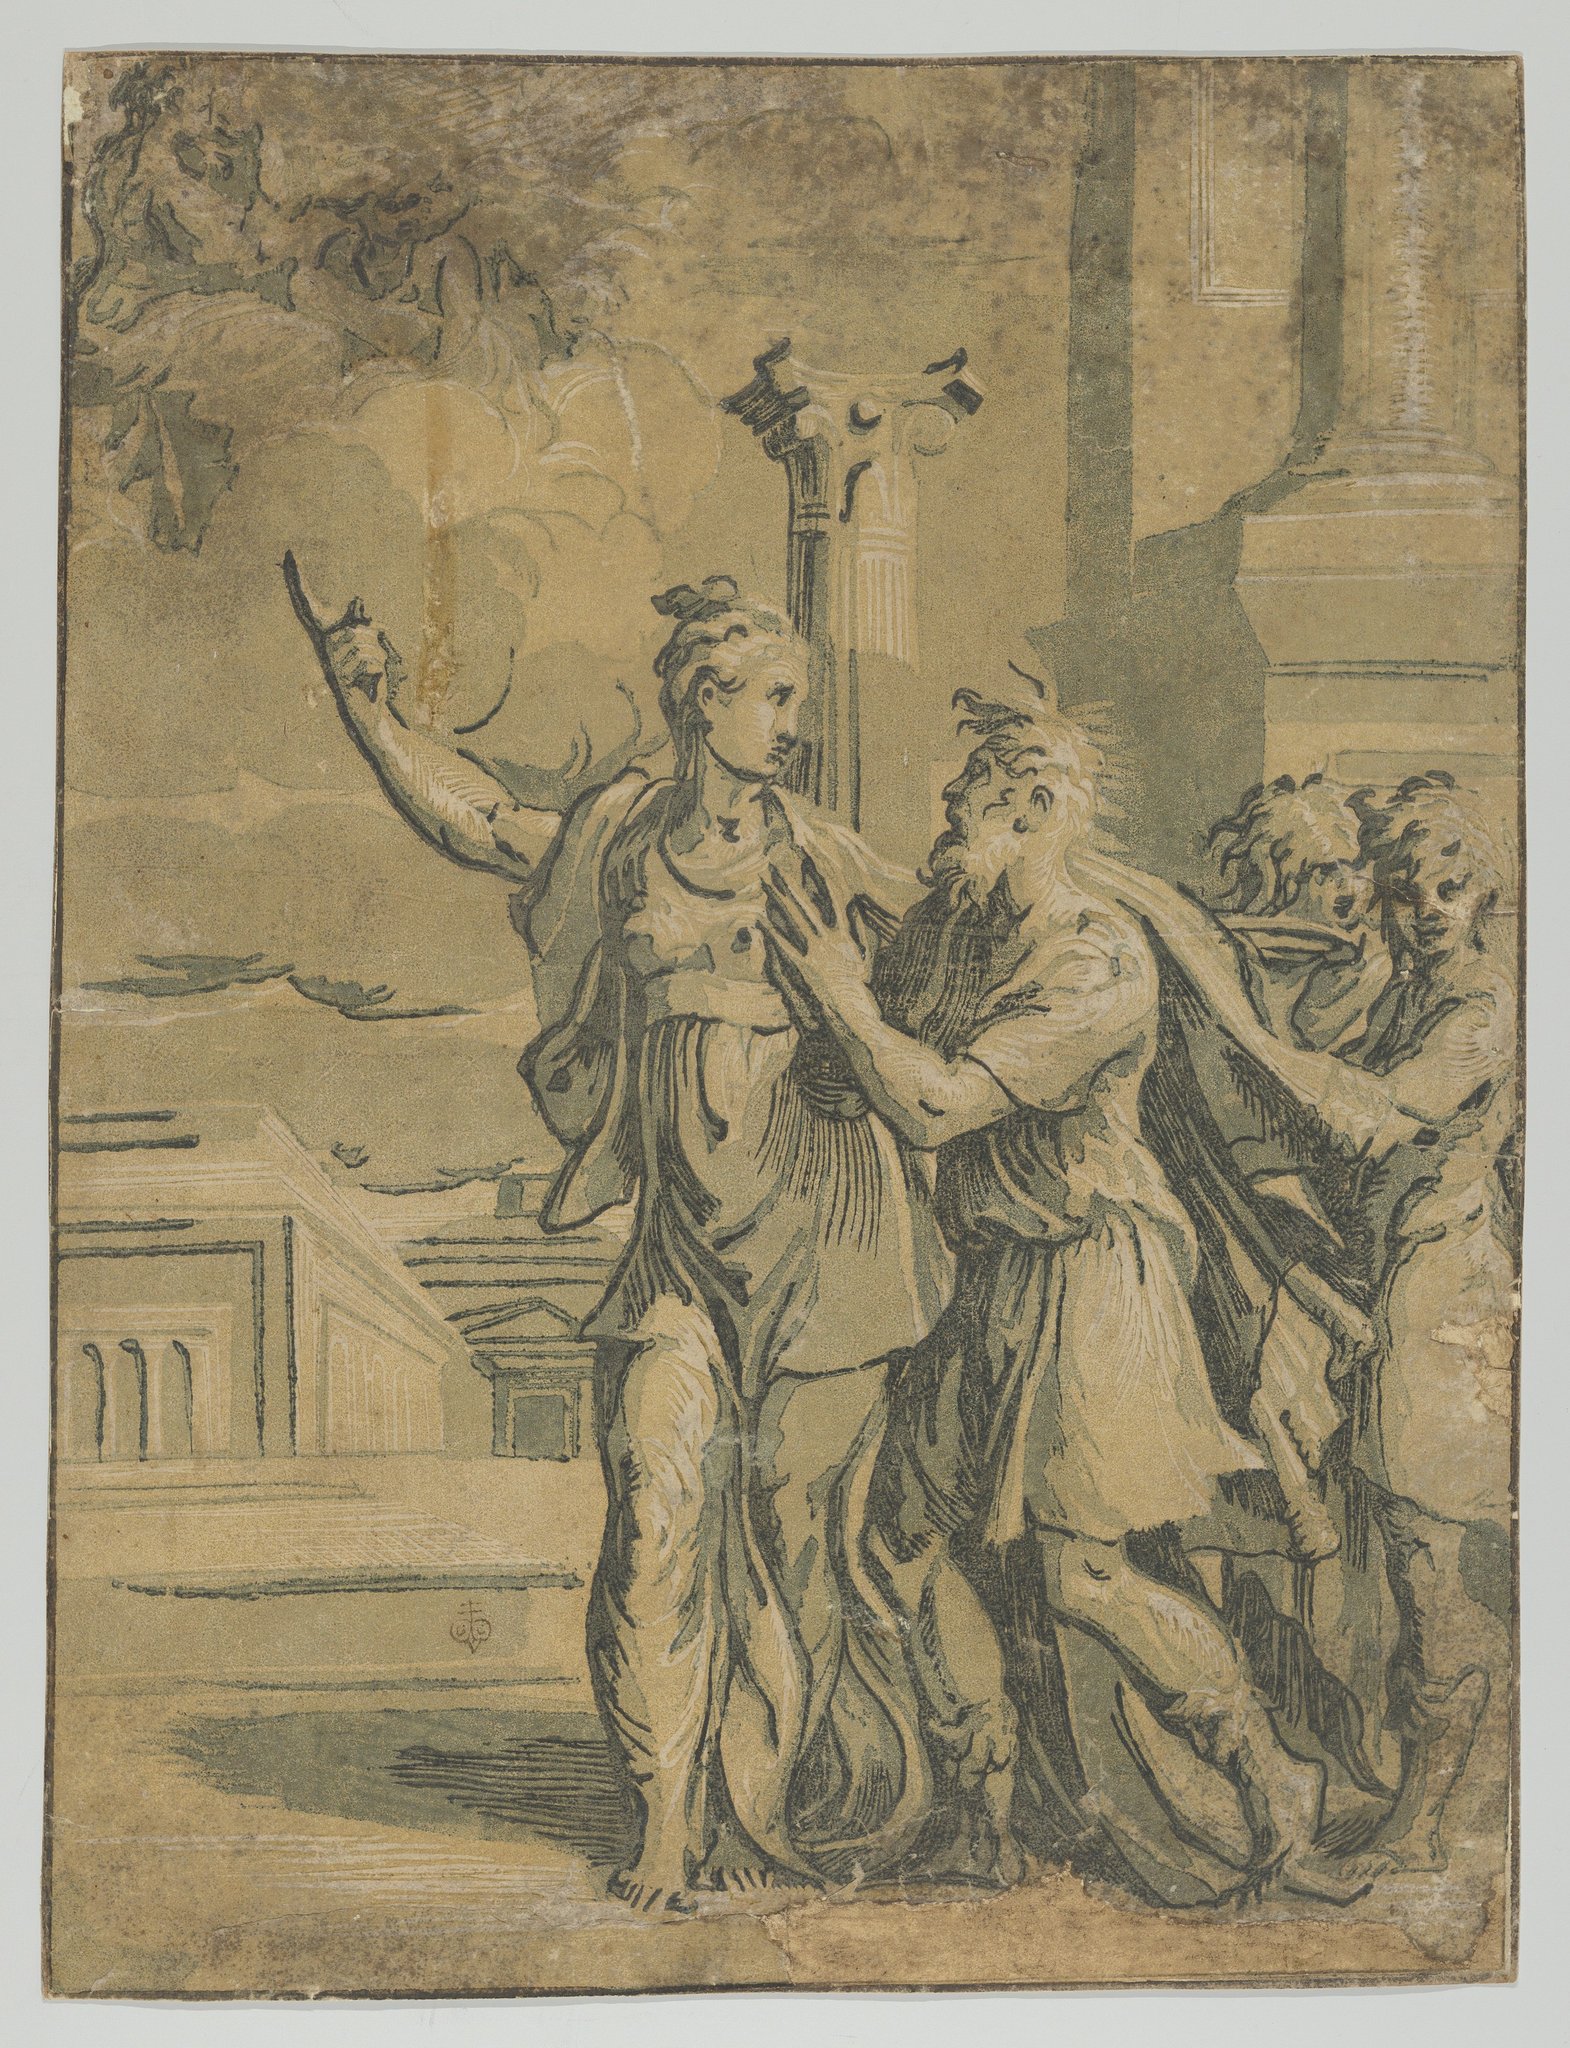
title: The Tirburtine Sibyl telling the Emperor Augustus of the coming in Christ, after Parmigianino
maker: anonymous, italian, 16th century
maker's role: artist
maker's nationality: italian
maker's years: 1500-1600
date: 1530-1540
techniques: woodcut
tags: emperor augustus,men,sibyl